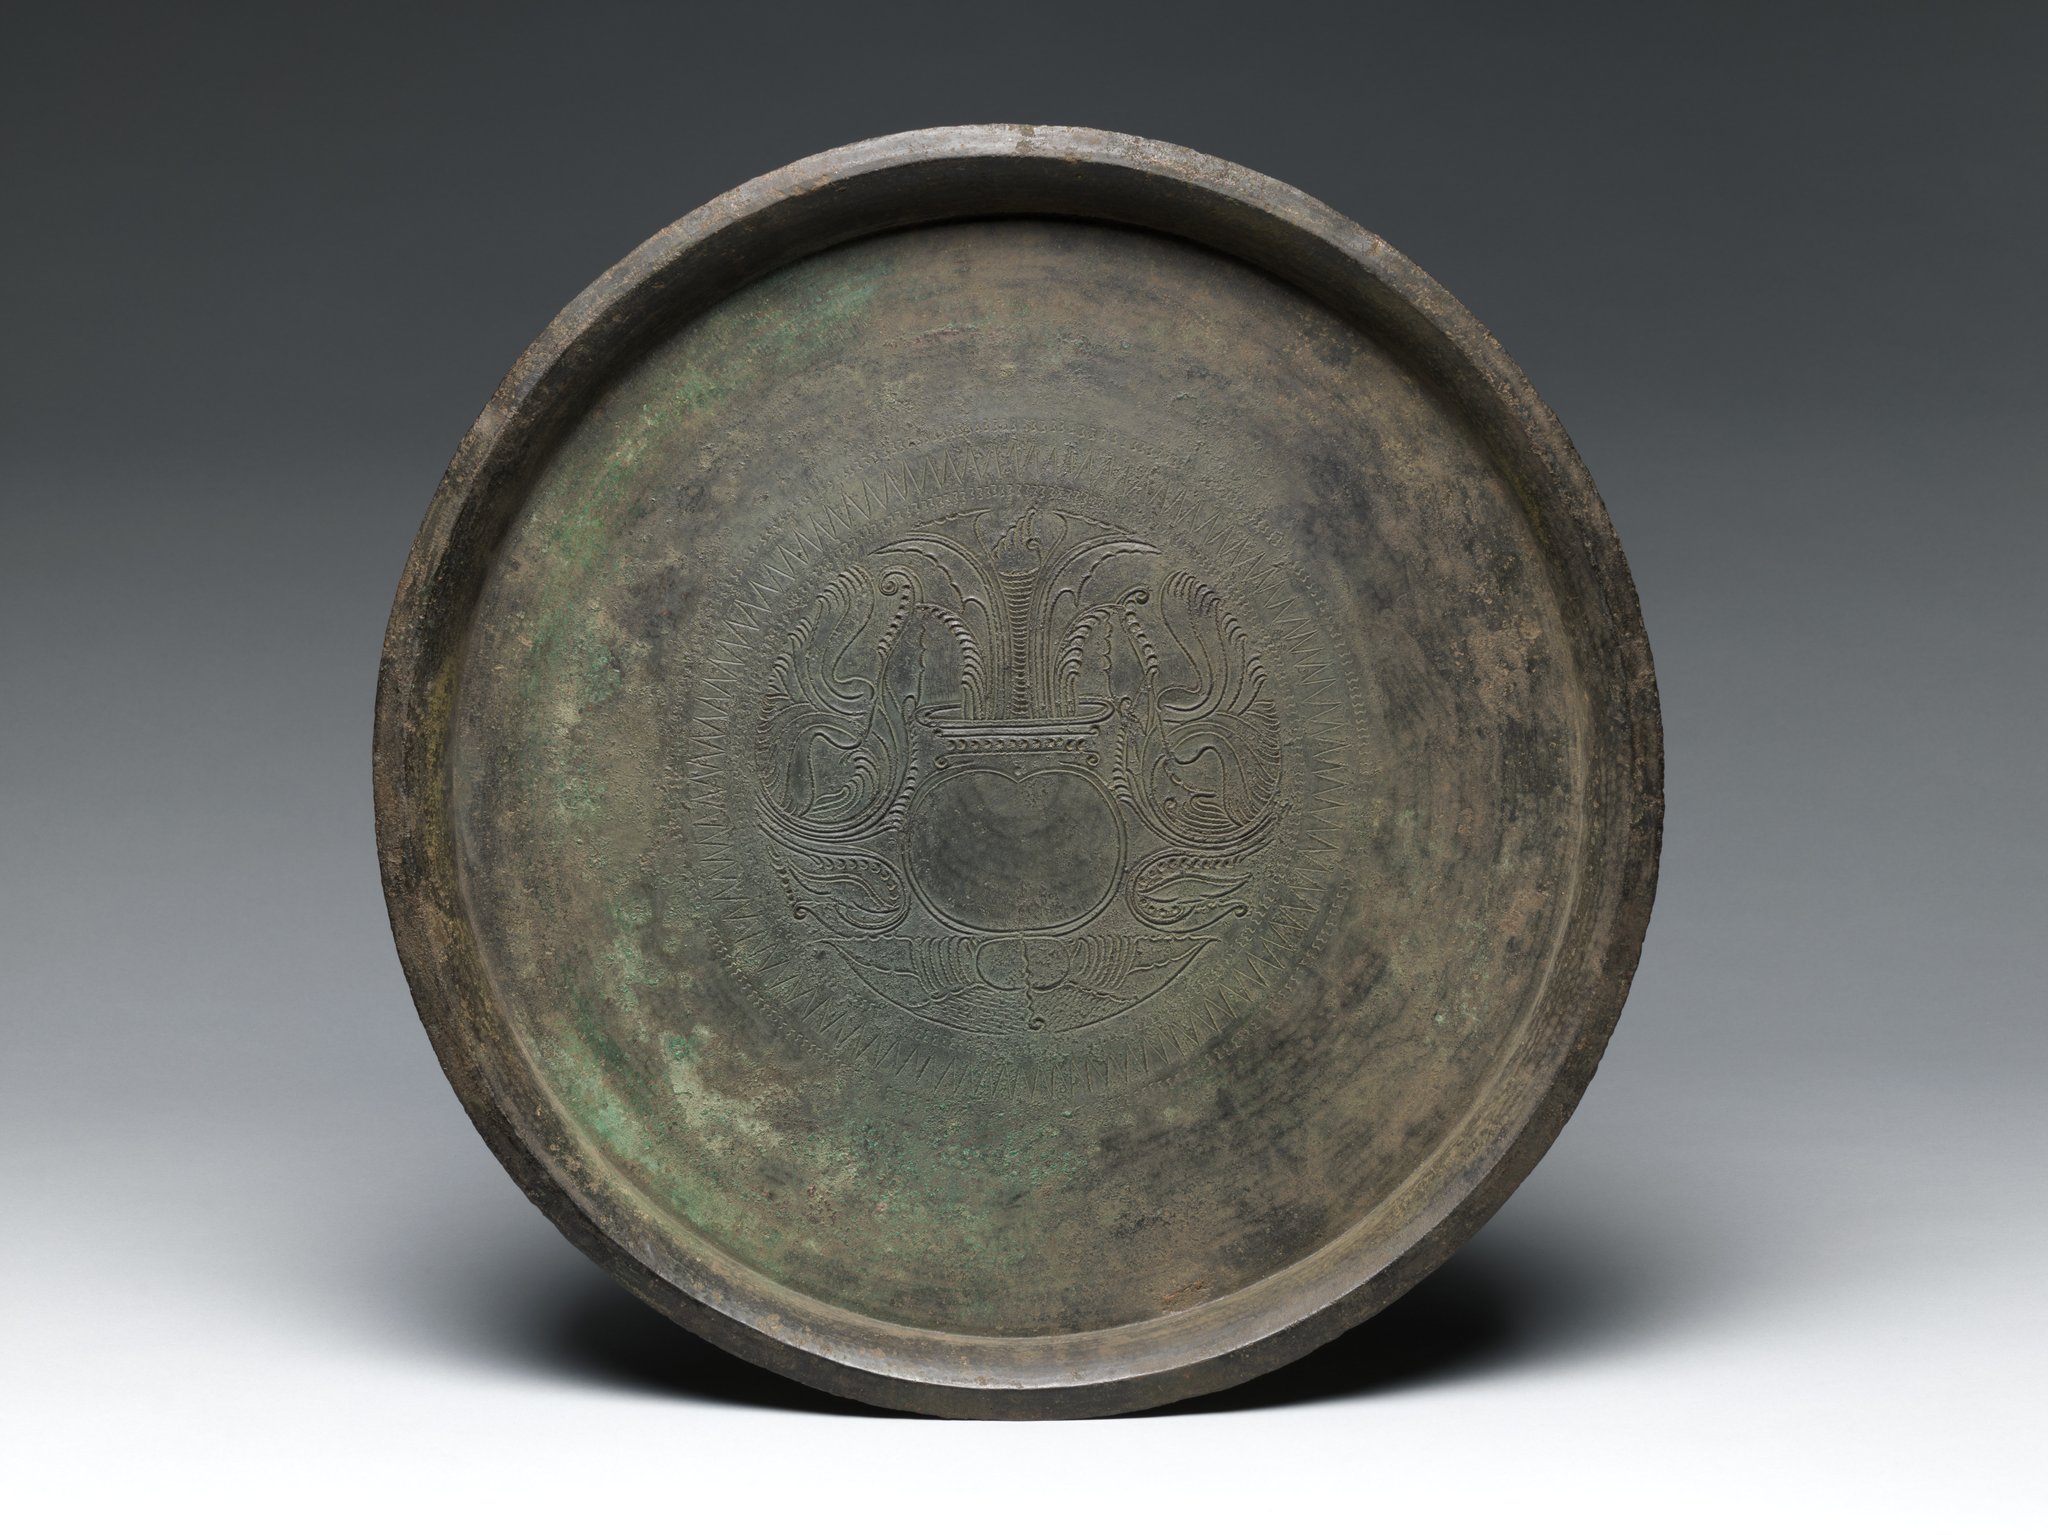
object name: offering tray talam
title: Offering Tray (Talam)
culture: indonesian, javanese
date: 901-1100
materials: bronze